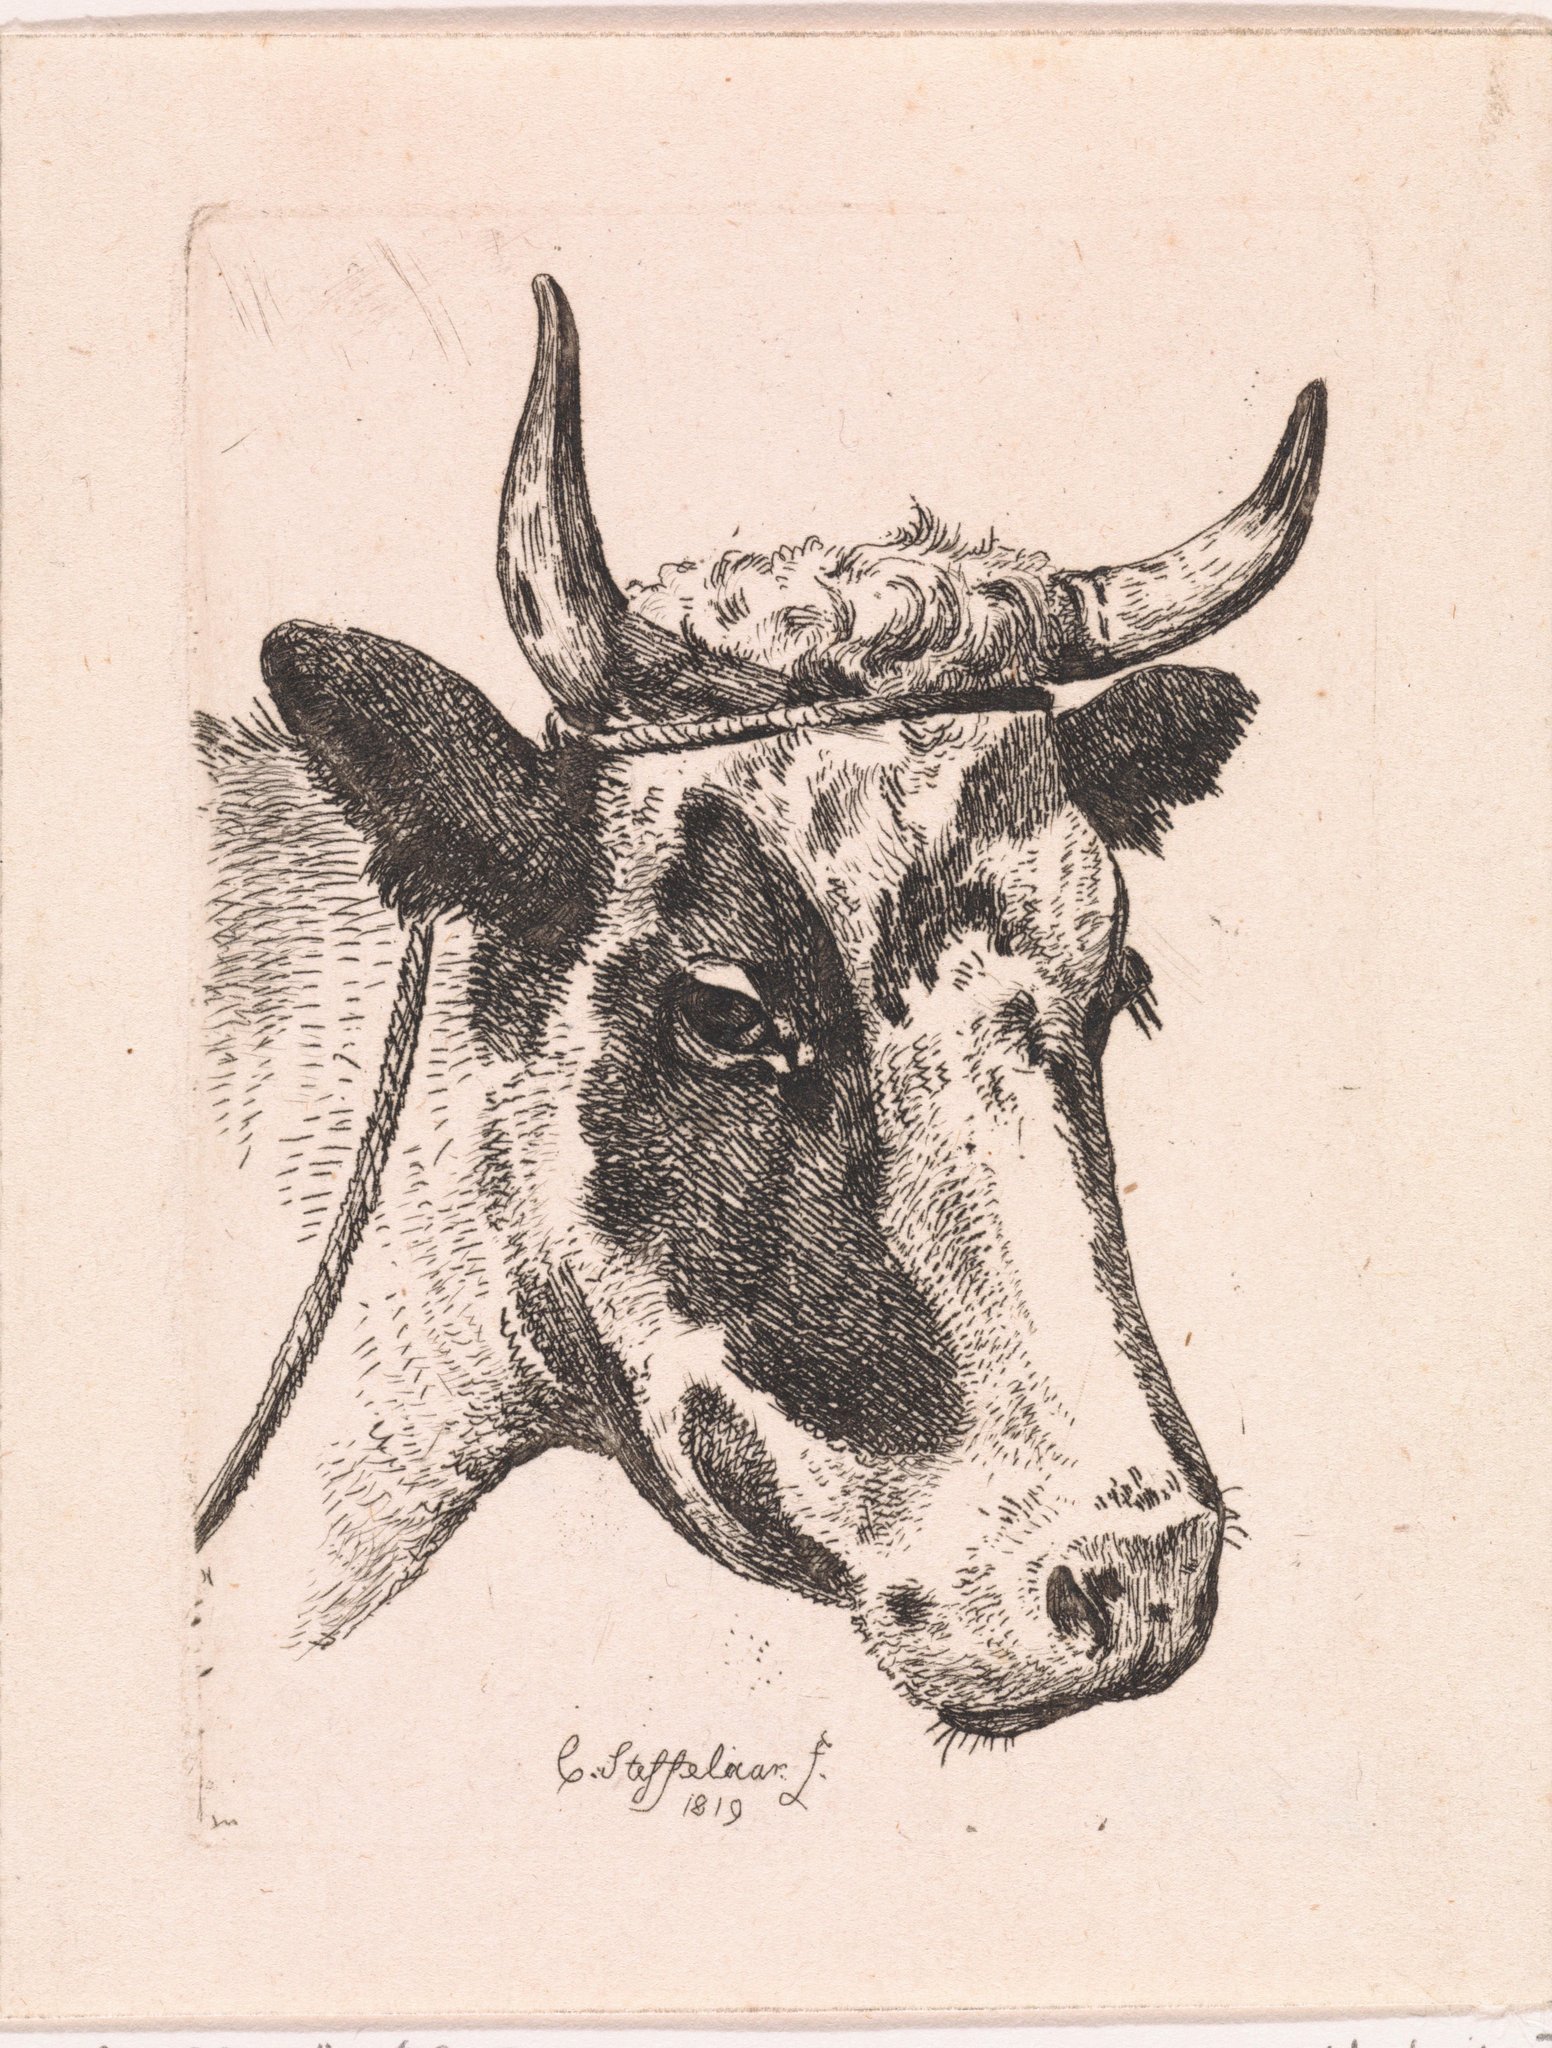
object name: print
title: Eerste suite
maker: cornelis steffelaar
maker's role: draughtsman, painter, print maker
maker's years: 1797-1861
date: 1819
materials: paper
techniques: etching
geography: amsterdam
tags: cow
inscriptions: collector's mark: Lugt 2228